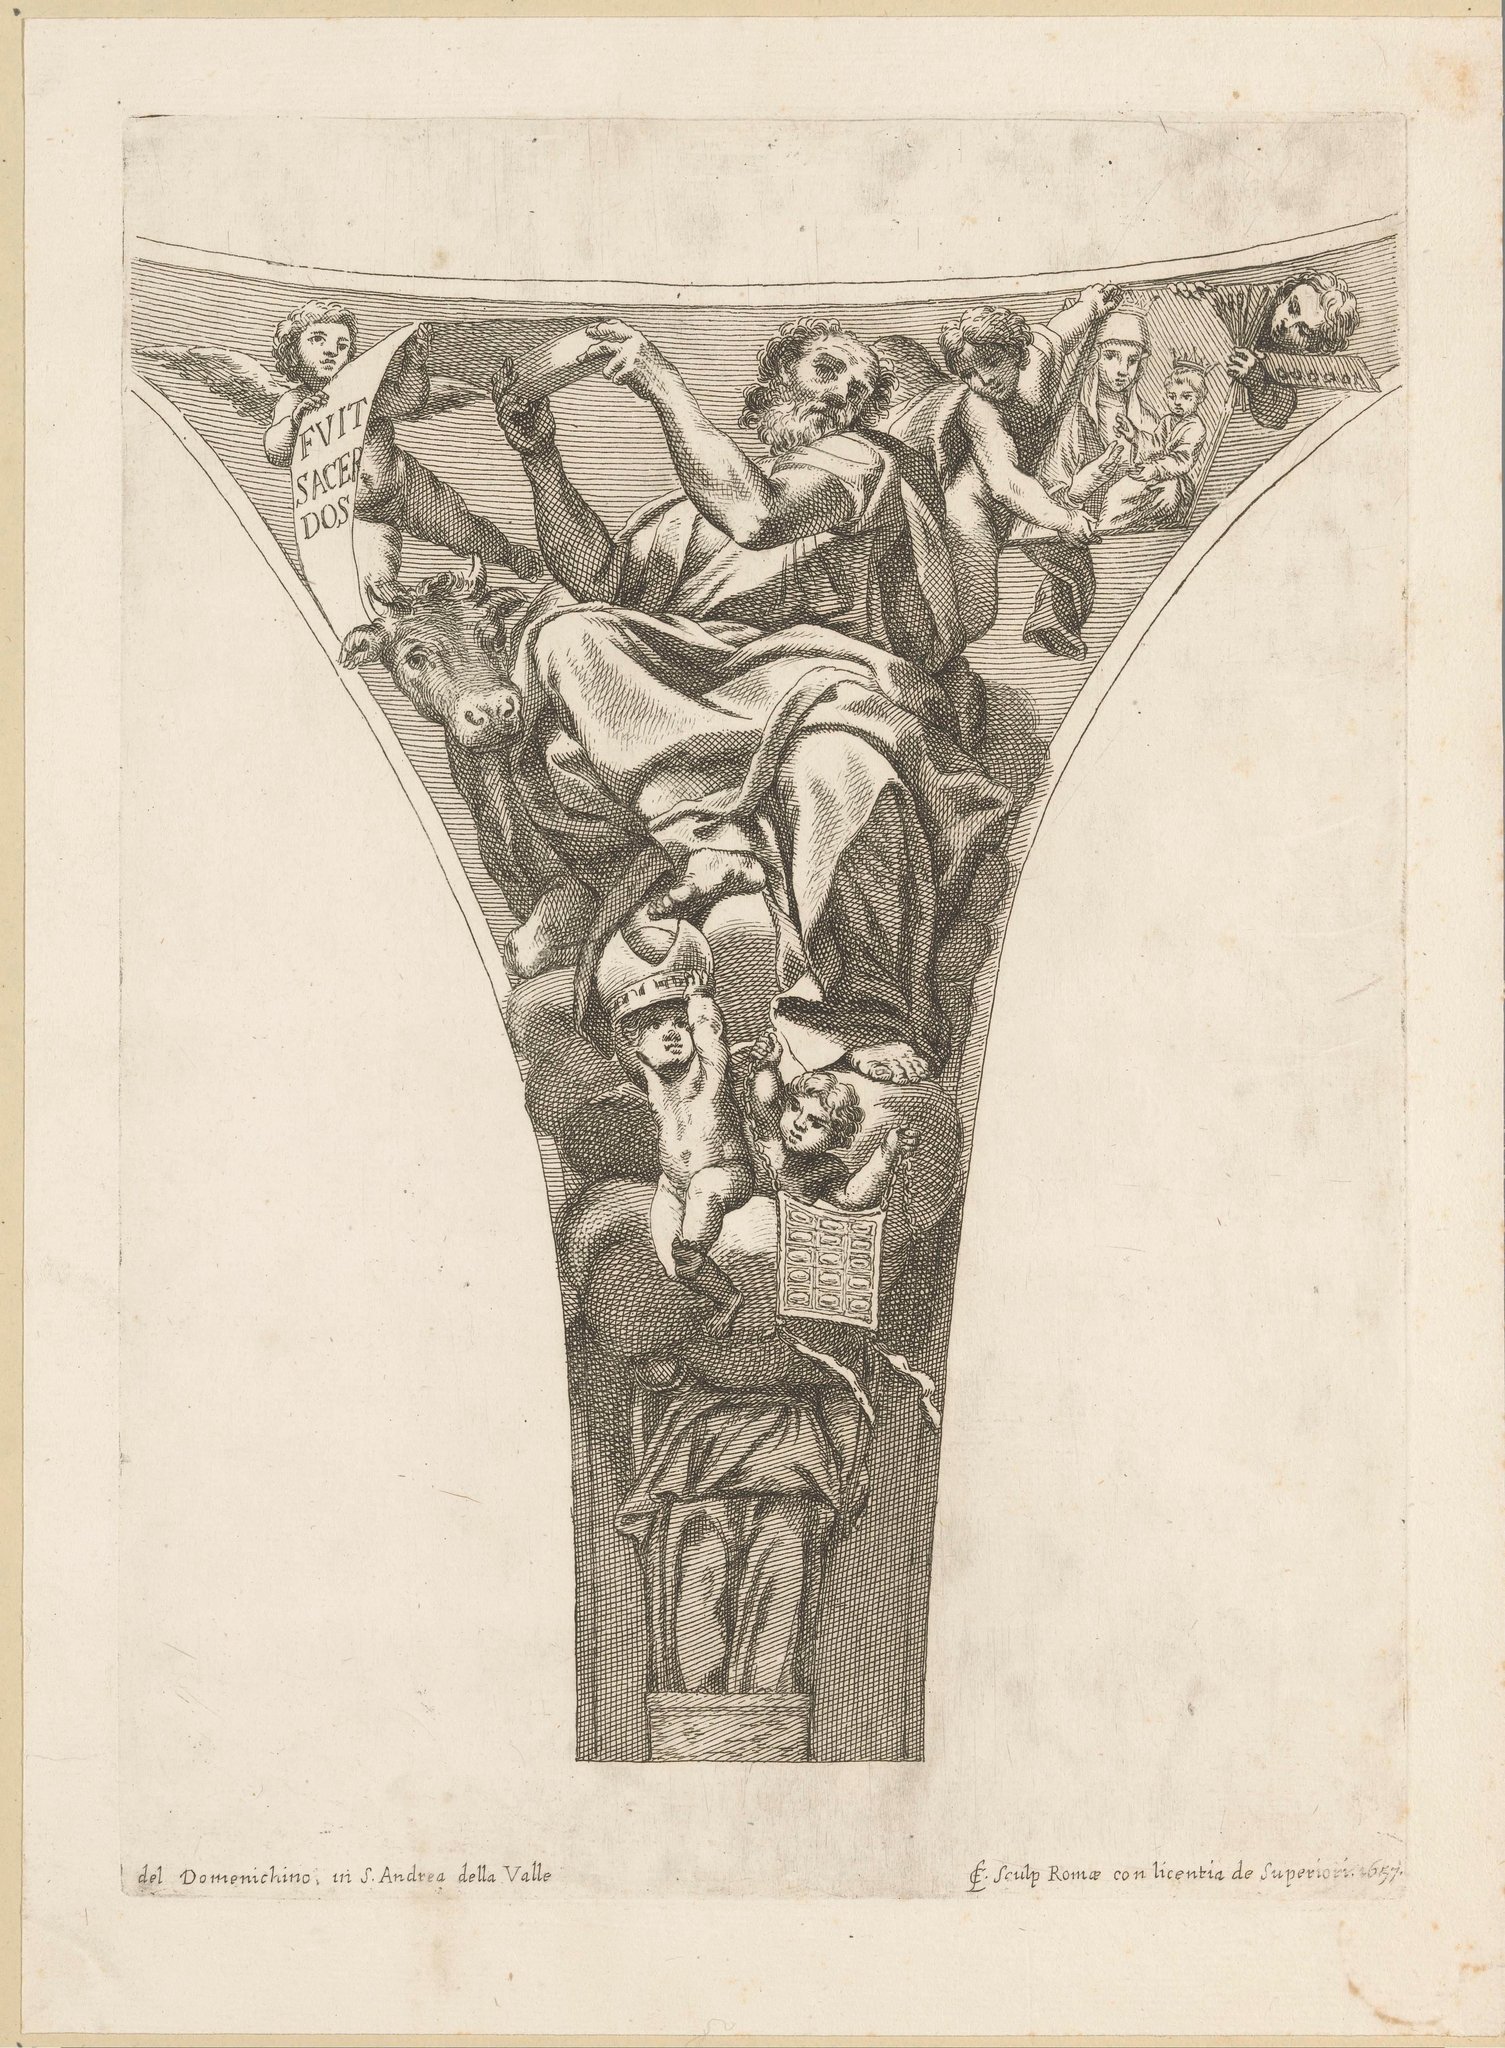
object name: print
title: Lucas de evangelist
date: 1657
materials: paper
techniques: etching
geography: rome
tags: luke the evangelist; possible attributes: book, (winged) ox, portrait of the virgin, surgical instruments, painter's utensils, scroll, vestments of high priest ~ jewish religion, st. luke painting or drawing the madonna from memory, ox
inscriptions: collector's mark: Lugt 240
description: Prent naar fresco in de Sant'Andrea della Valle in Rome.